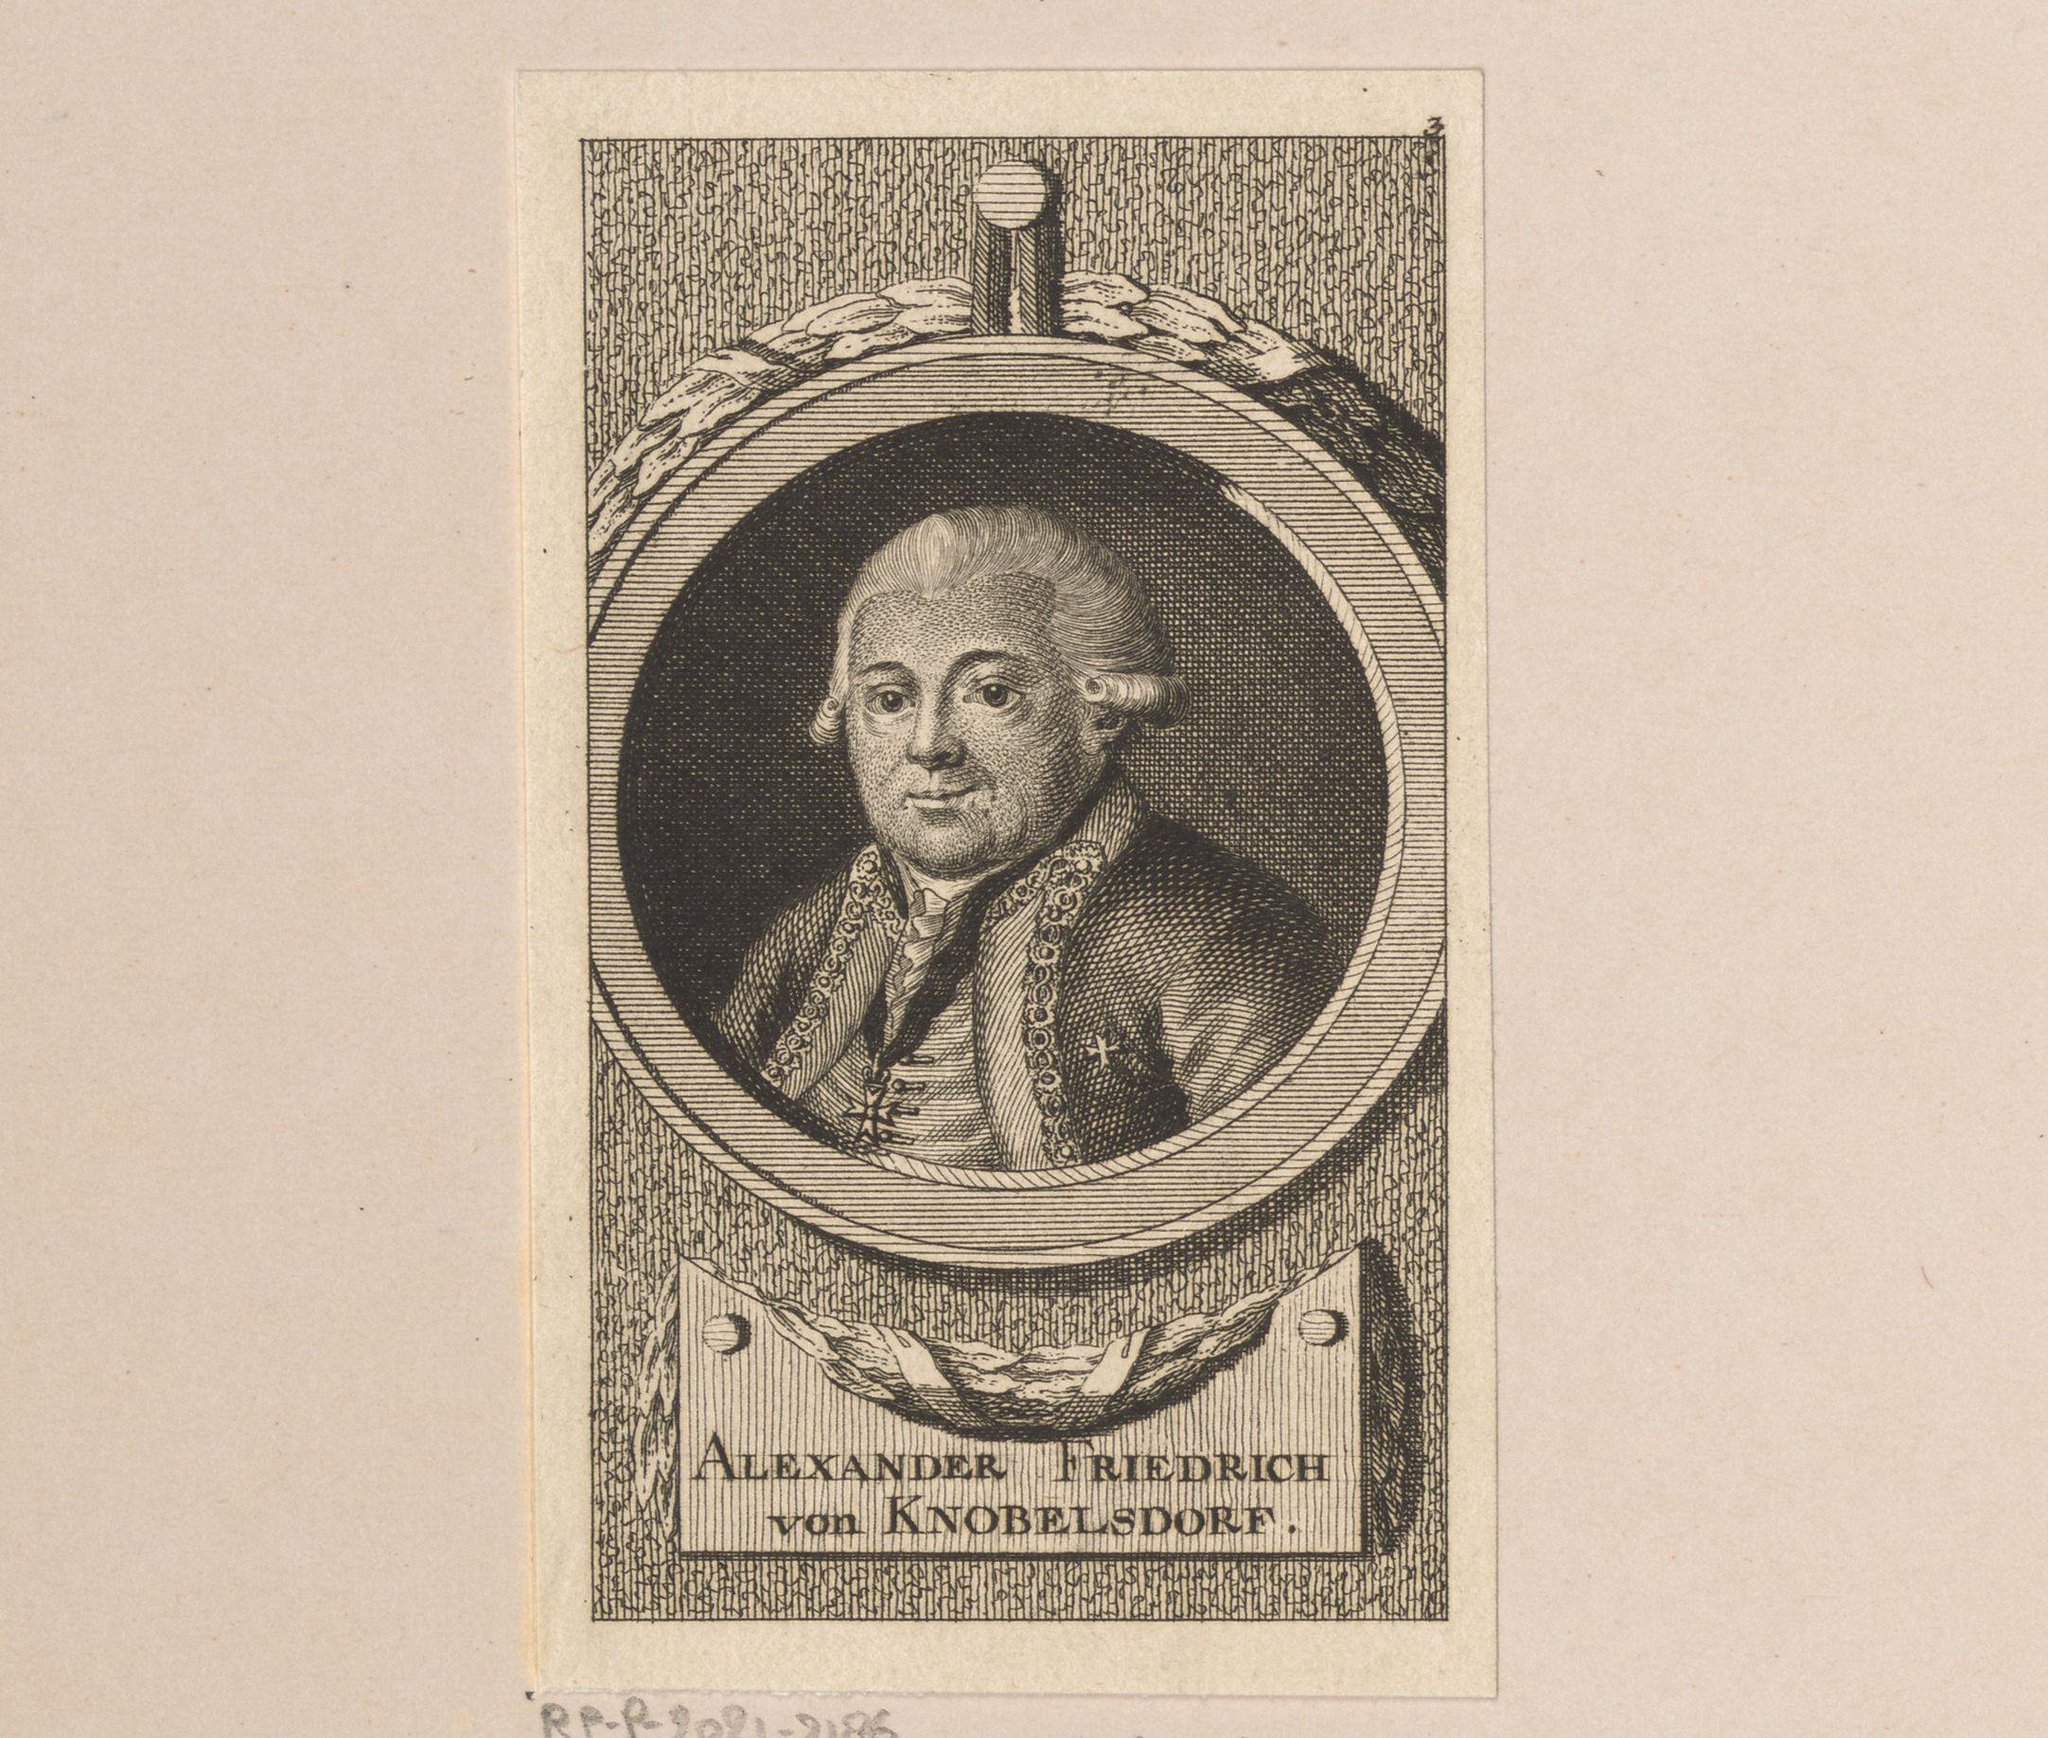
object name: print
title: Portret van Alexander von Knobelsdorff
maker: peter haas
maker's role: print maker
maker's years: 1754-1804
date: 1764-1804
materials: paper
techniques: engraving, etching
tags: alexander von knobelsdorff, historical persons